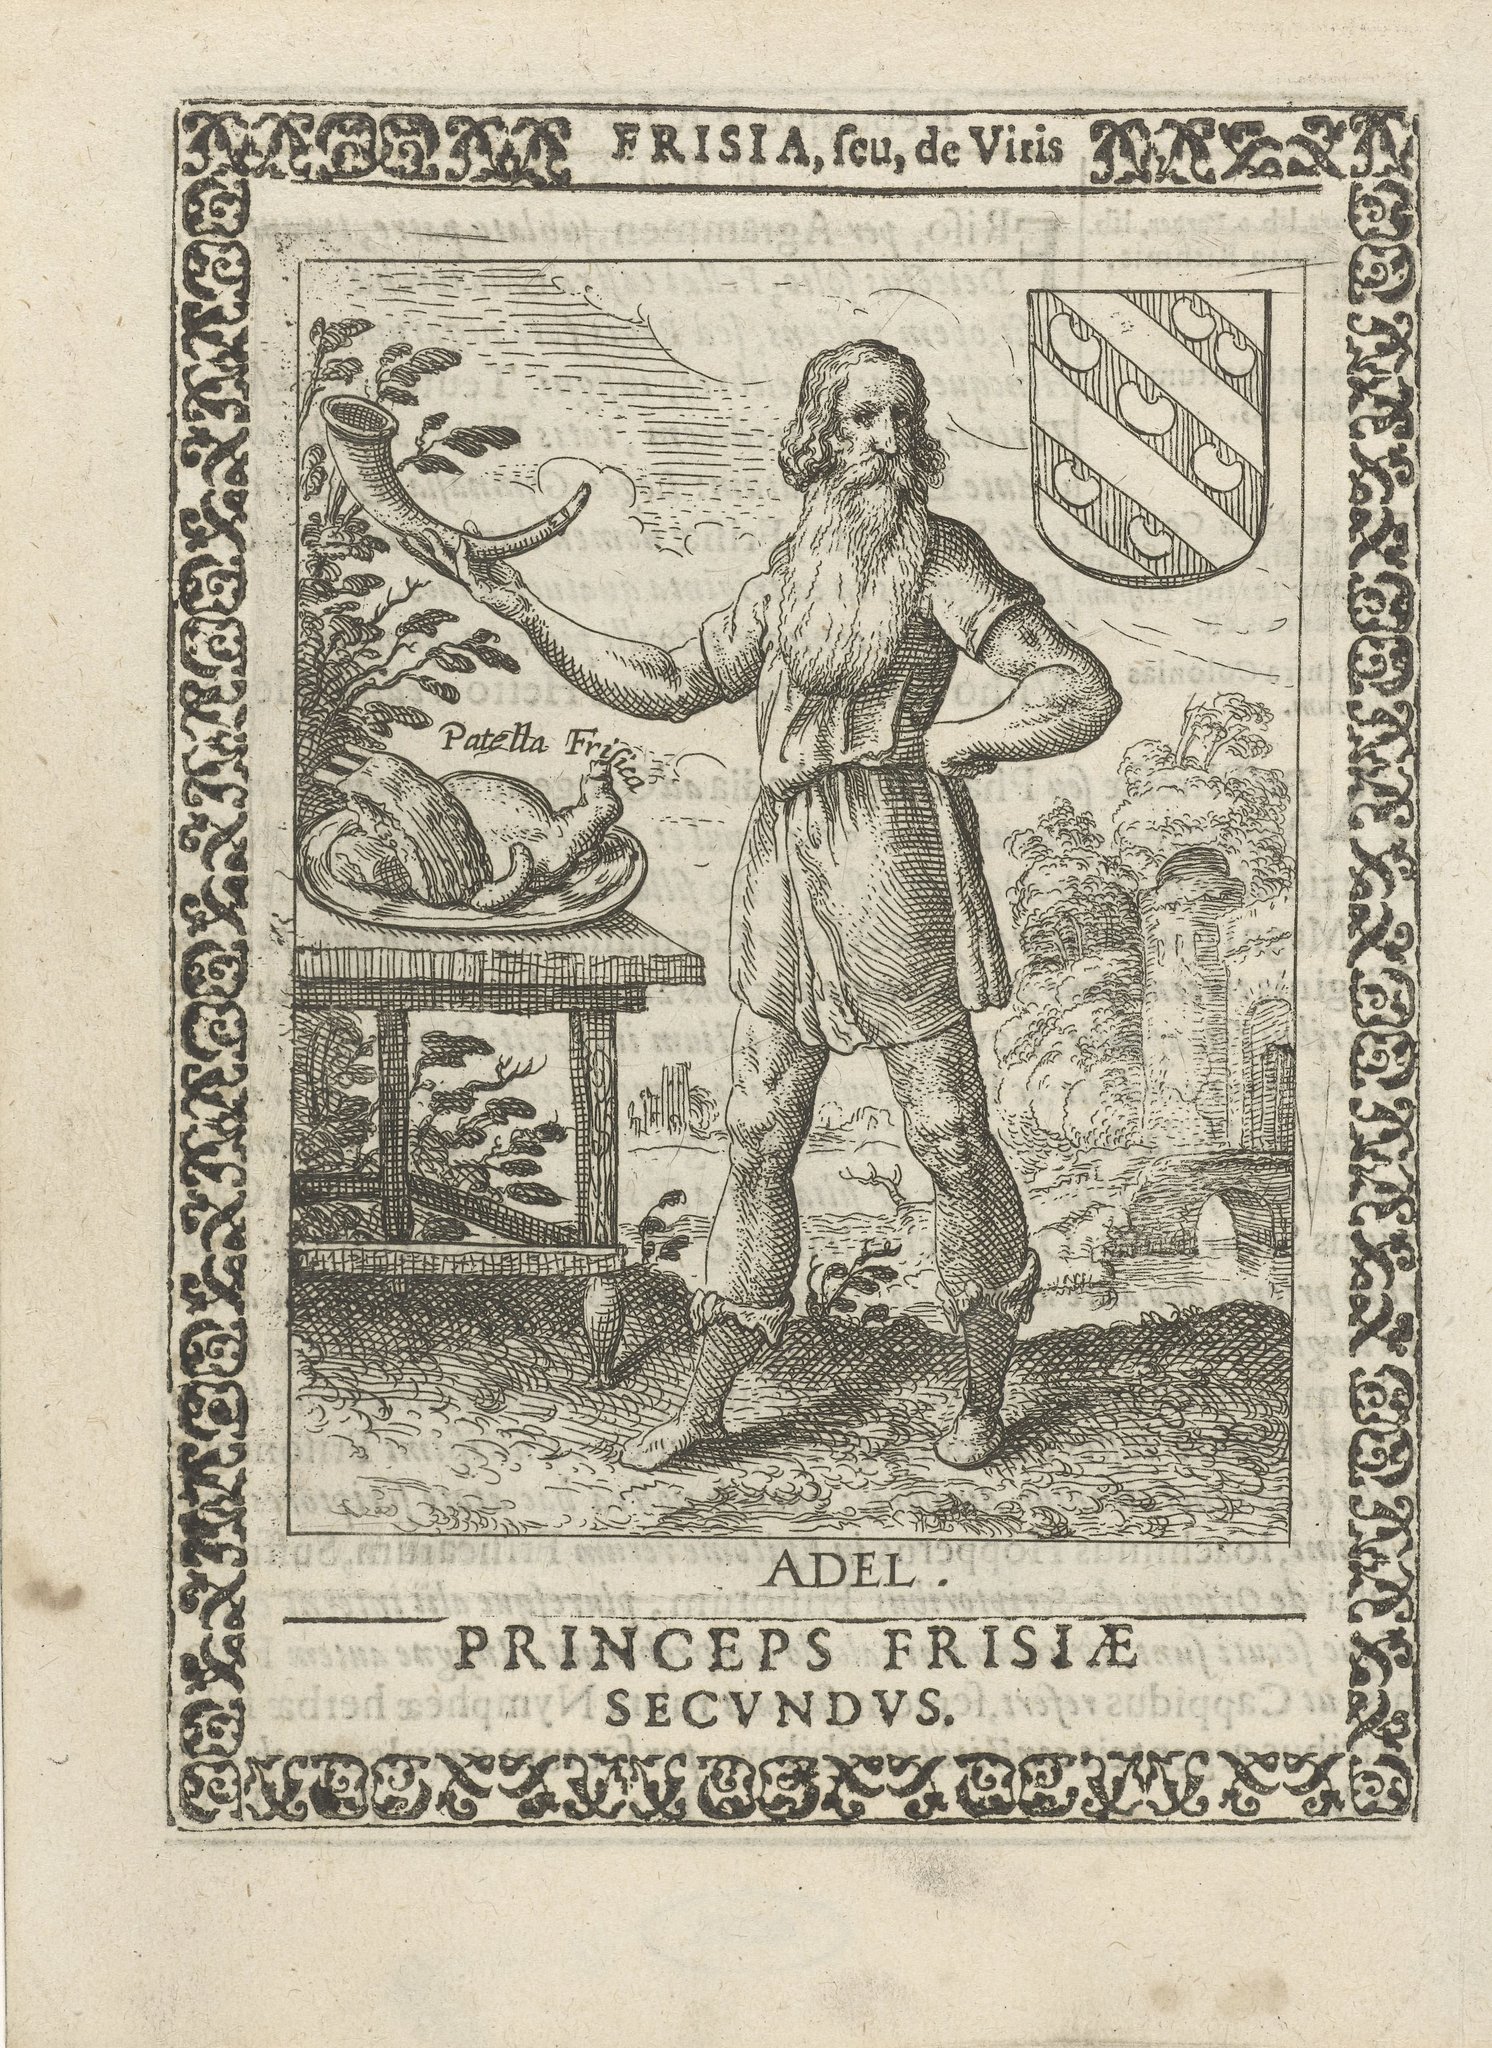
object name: print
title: Frisia, sev, de Viris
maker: pieter feddes van harlingen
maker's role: painter, print maker, publisher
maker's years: 1586-1623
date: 1618-1620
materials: paper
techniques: etching, letterpress printing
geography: friesland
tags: ruler, sovereign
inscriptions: collector's mark: Lugt 2228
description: Adel, tweede prins van Friesland. Staande ten voeten uit, hoorn in de hand, bij een tafel. In een ornamentale omlijsting. Illustratie, met tekst op achterzijde, afkomstig uit het boek: Frisia seu de viris rebusque Frisiae illustribus libri duo.